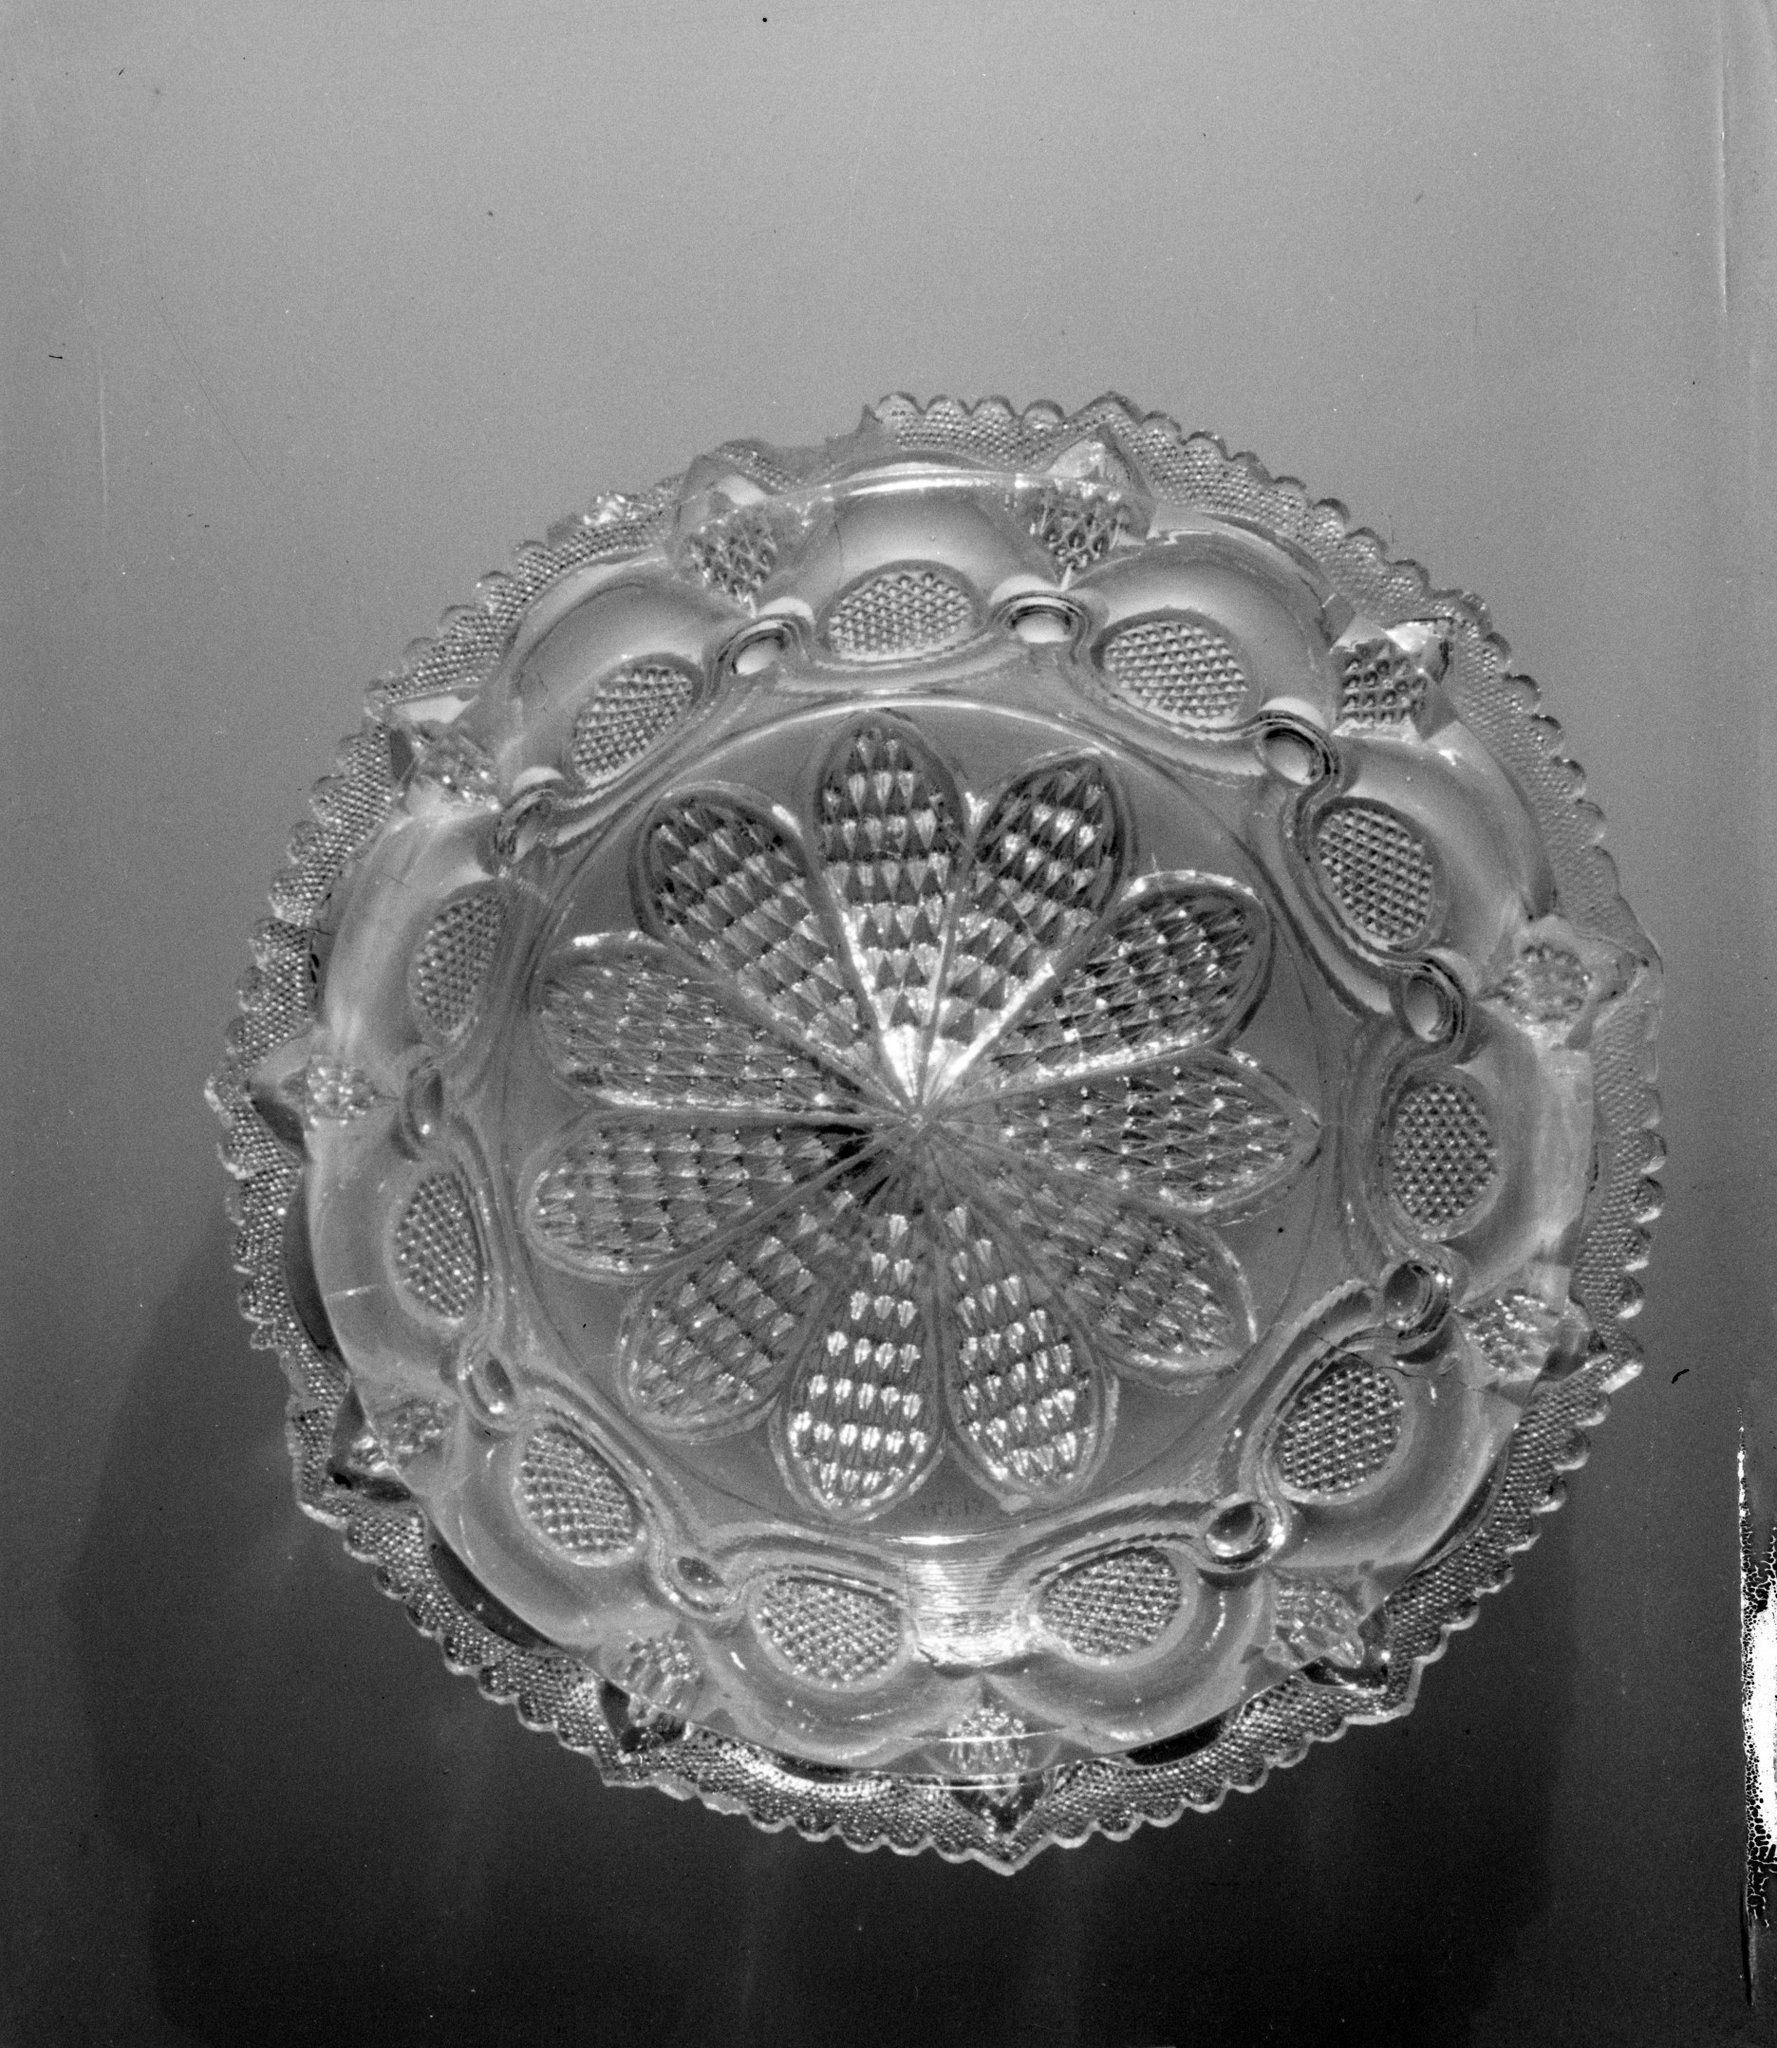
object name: bowl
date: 1835-1840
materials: glass